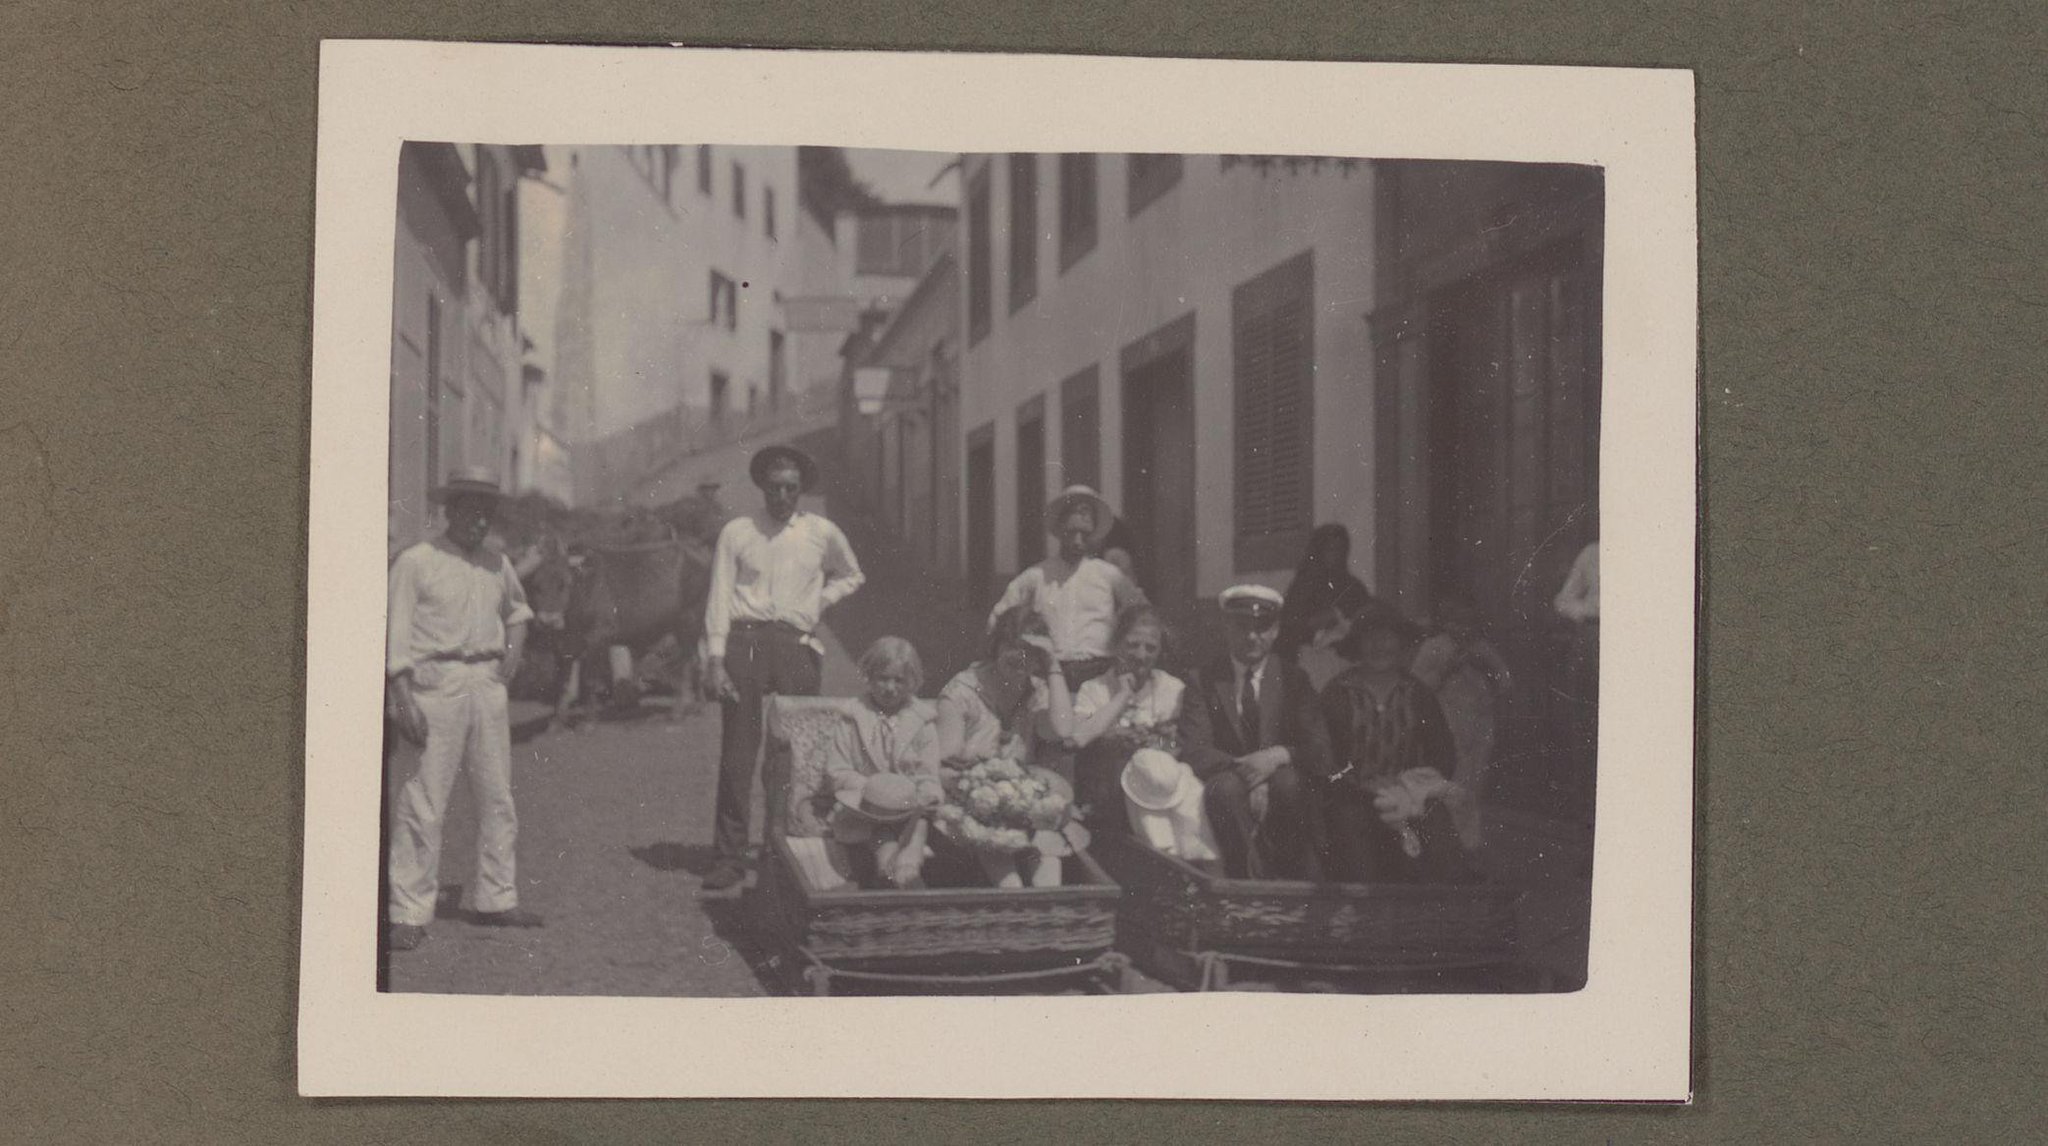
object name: photograph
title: Straatgezicht te Madeira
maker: Anonymous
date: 1925-1927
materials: photographic support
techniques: photography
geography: suriname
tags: jetten, familie, moengo, madeira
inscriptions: inscription: ‘Madeira’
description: Straatgezicht tijdens bezoek aan Madeira. Foto op een bladzijde van een los albumblad. Onderdeel van het ensemble met foto's van de familie van ingenieur Jetten in de mijnbouwstad Moengo in Suriname.